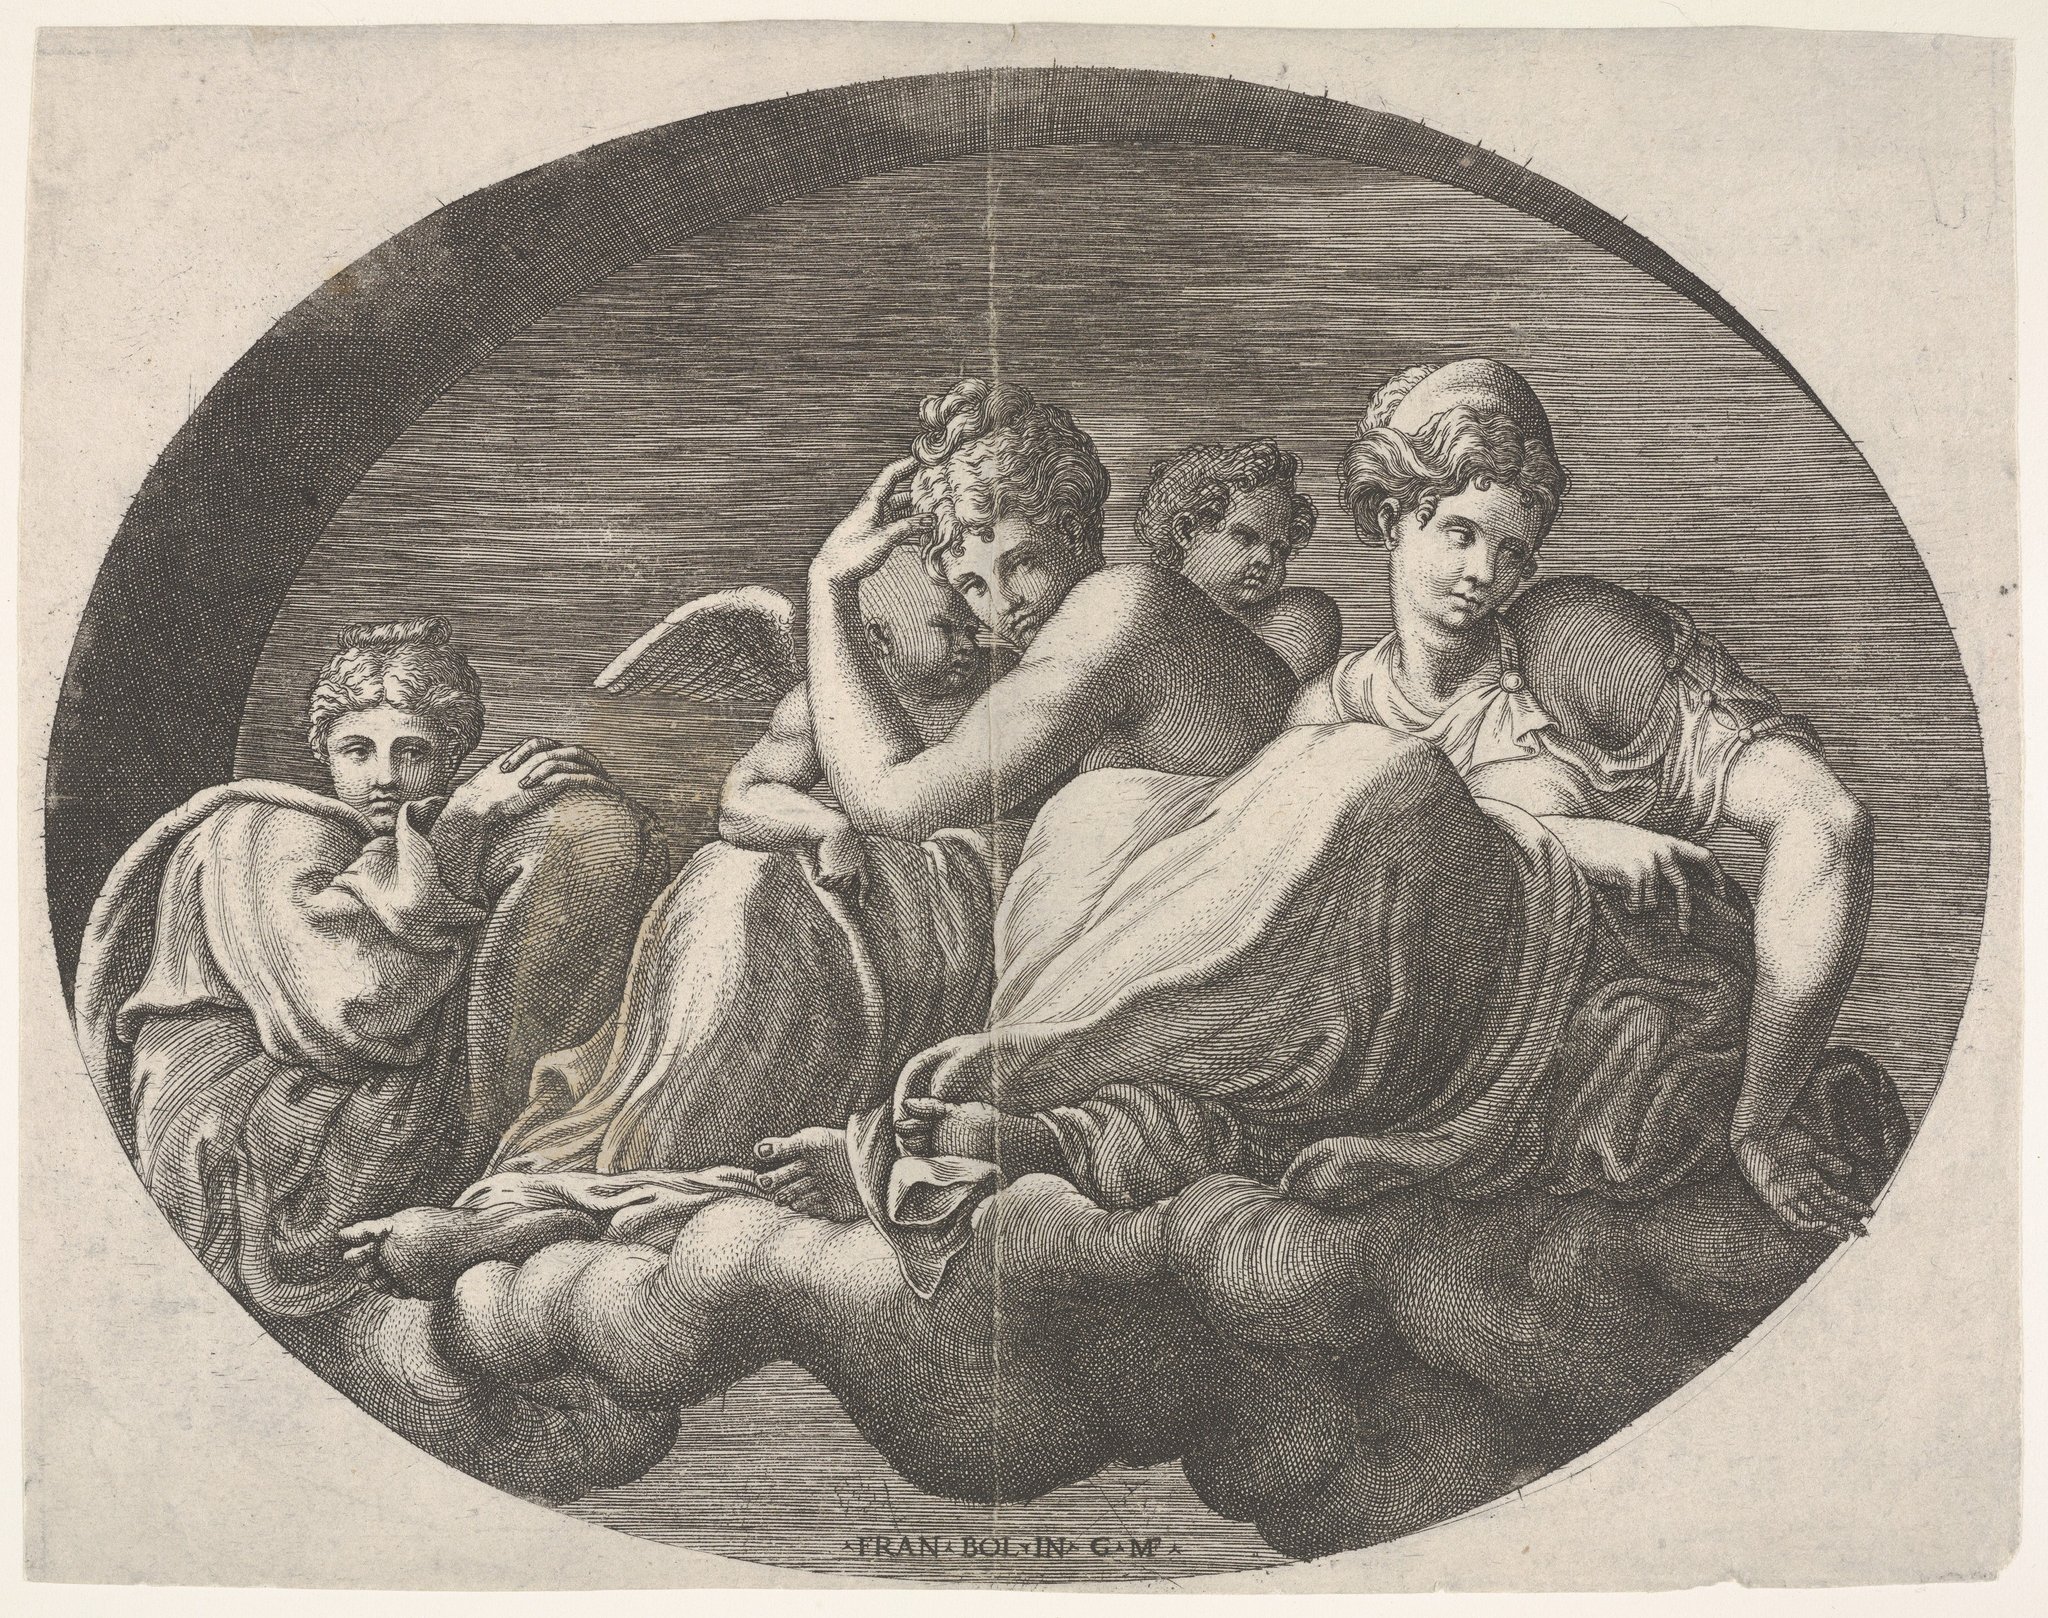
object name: print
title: Venus and Cupid and two other goddesses seated on a cloud under an arch and accompanied by a putto, an oval composition, from a series of eight compositions after Francesco Primaticcio's designs for the ceiling of the Ulysses Gallery (destroyed 1738-39) at Fontainebleau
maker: giorgio ghisi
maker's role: artist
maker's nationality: italian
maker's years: 1515-1582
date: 1560-1569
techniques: engraving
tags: cupid,venus,goddess